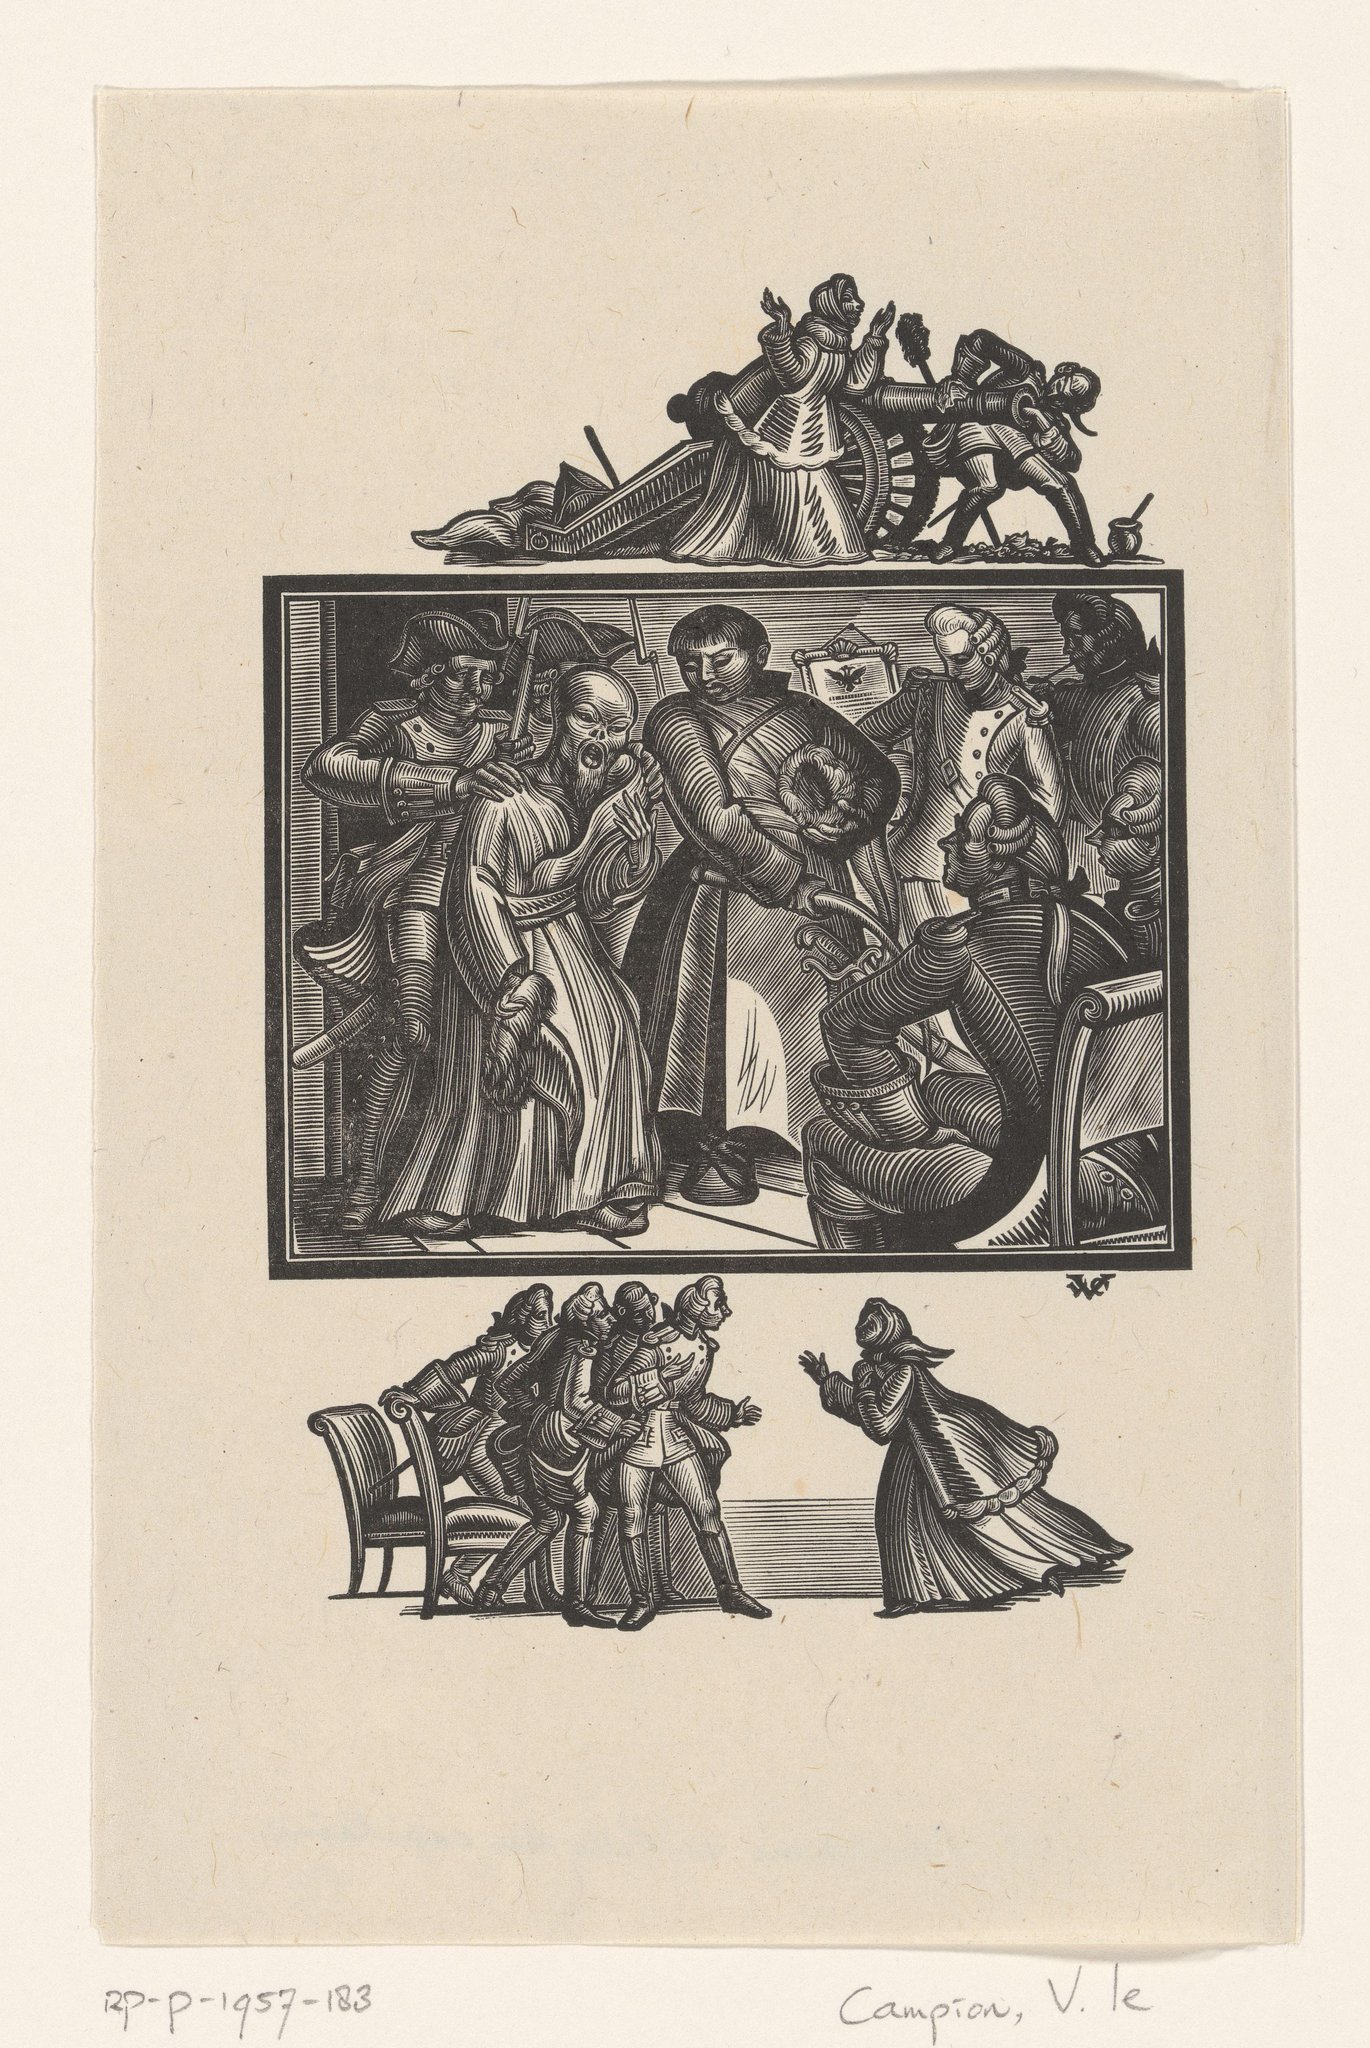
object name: book illustration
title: Arrestatie van kale man door soldaten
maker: valentin le campion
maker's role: print maker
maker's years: 1861-1952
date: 1953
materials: paper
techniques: engraving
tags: ranks (in the army, navy, air force), arrest (of criminal)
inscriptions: collector's mark: Lugt 2228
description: Een kale man gekleed in een gewaad wordt voor een groep soldaten geleid. Boven en onder de voorstelling een dame die hulp vraagt aan soldaten.